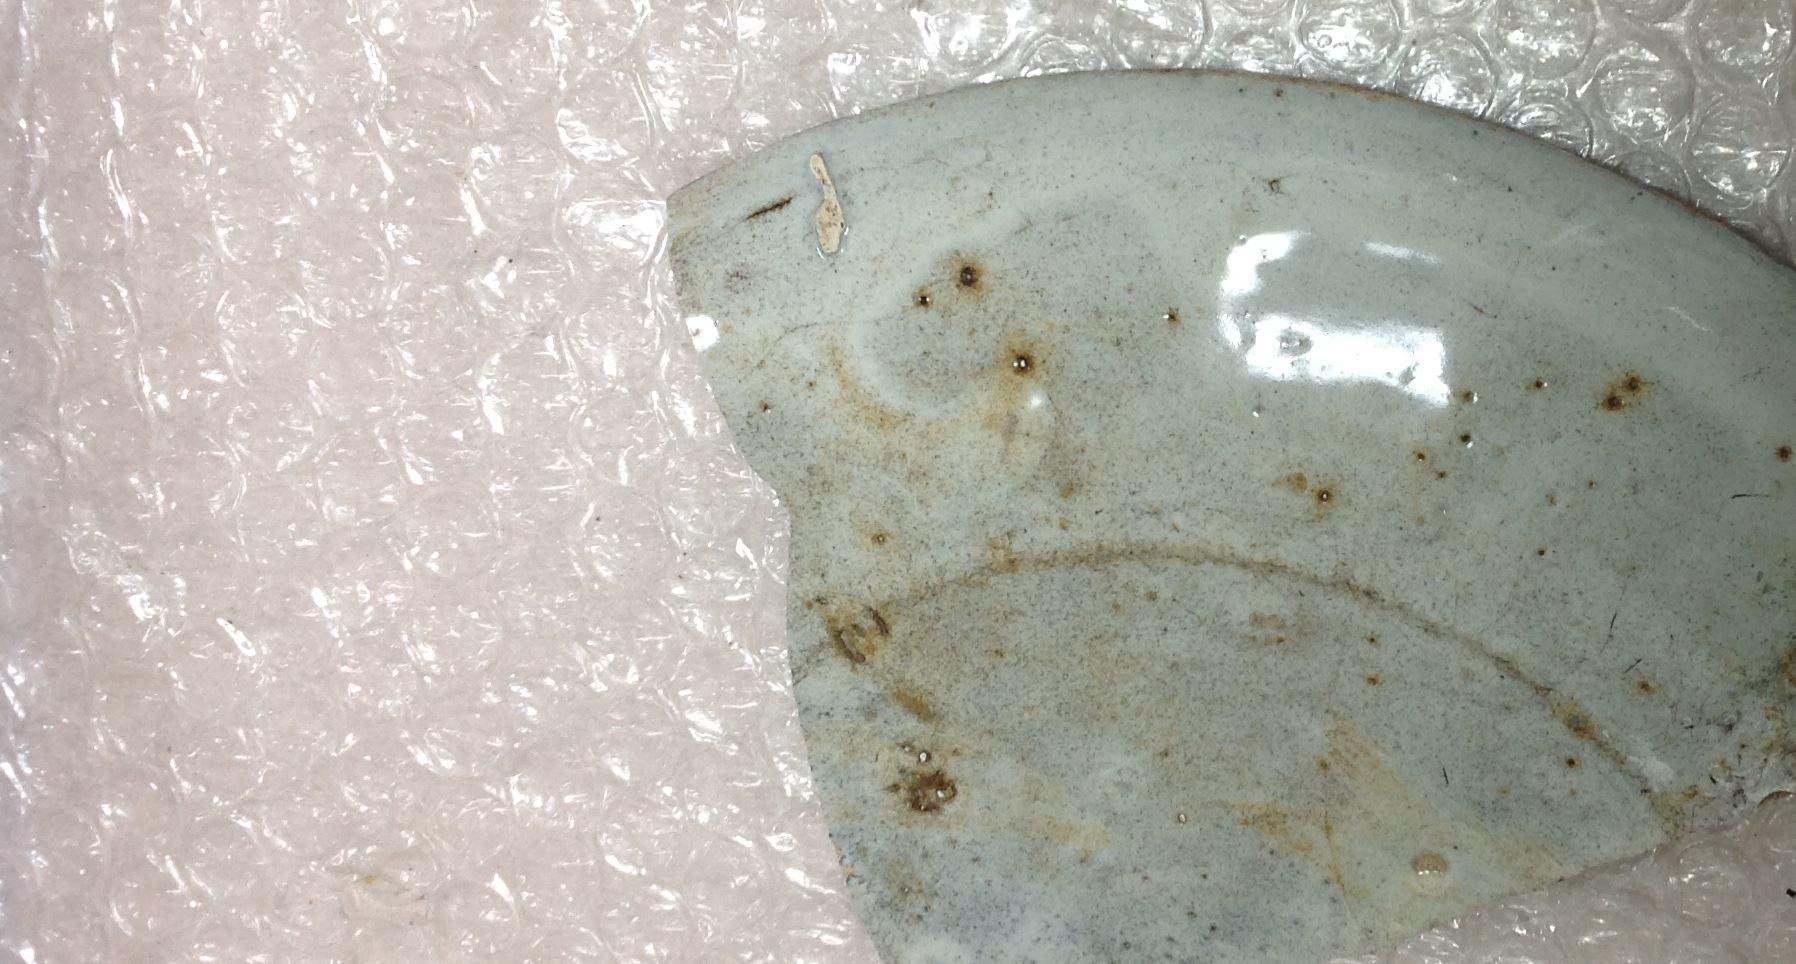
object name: tabakspijp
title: Gemerkte tabakspijp van pijpaarde, beschadigd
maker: Anonymous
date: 1500-1799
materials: clay